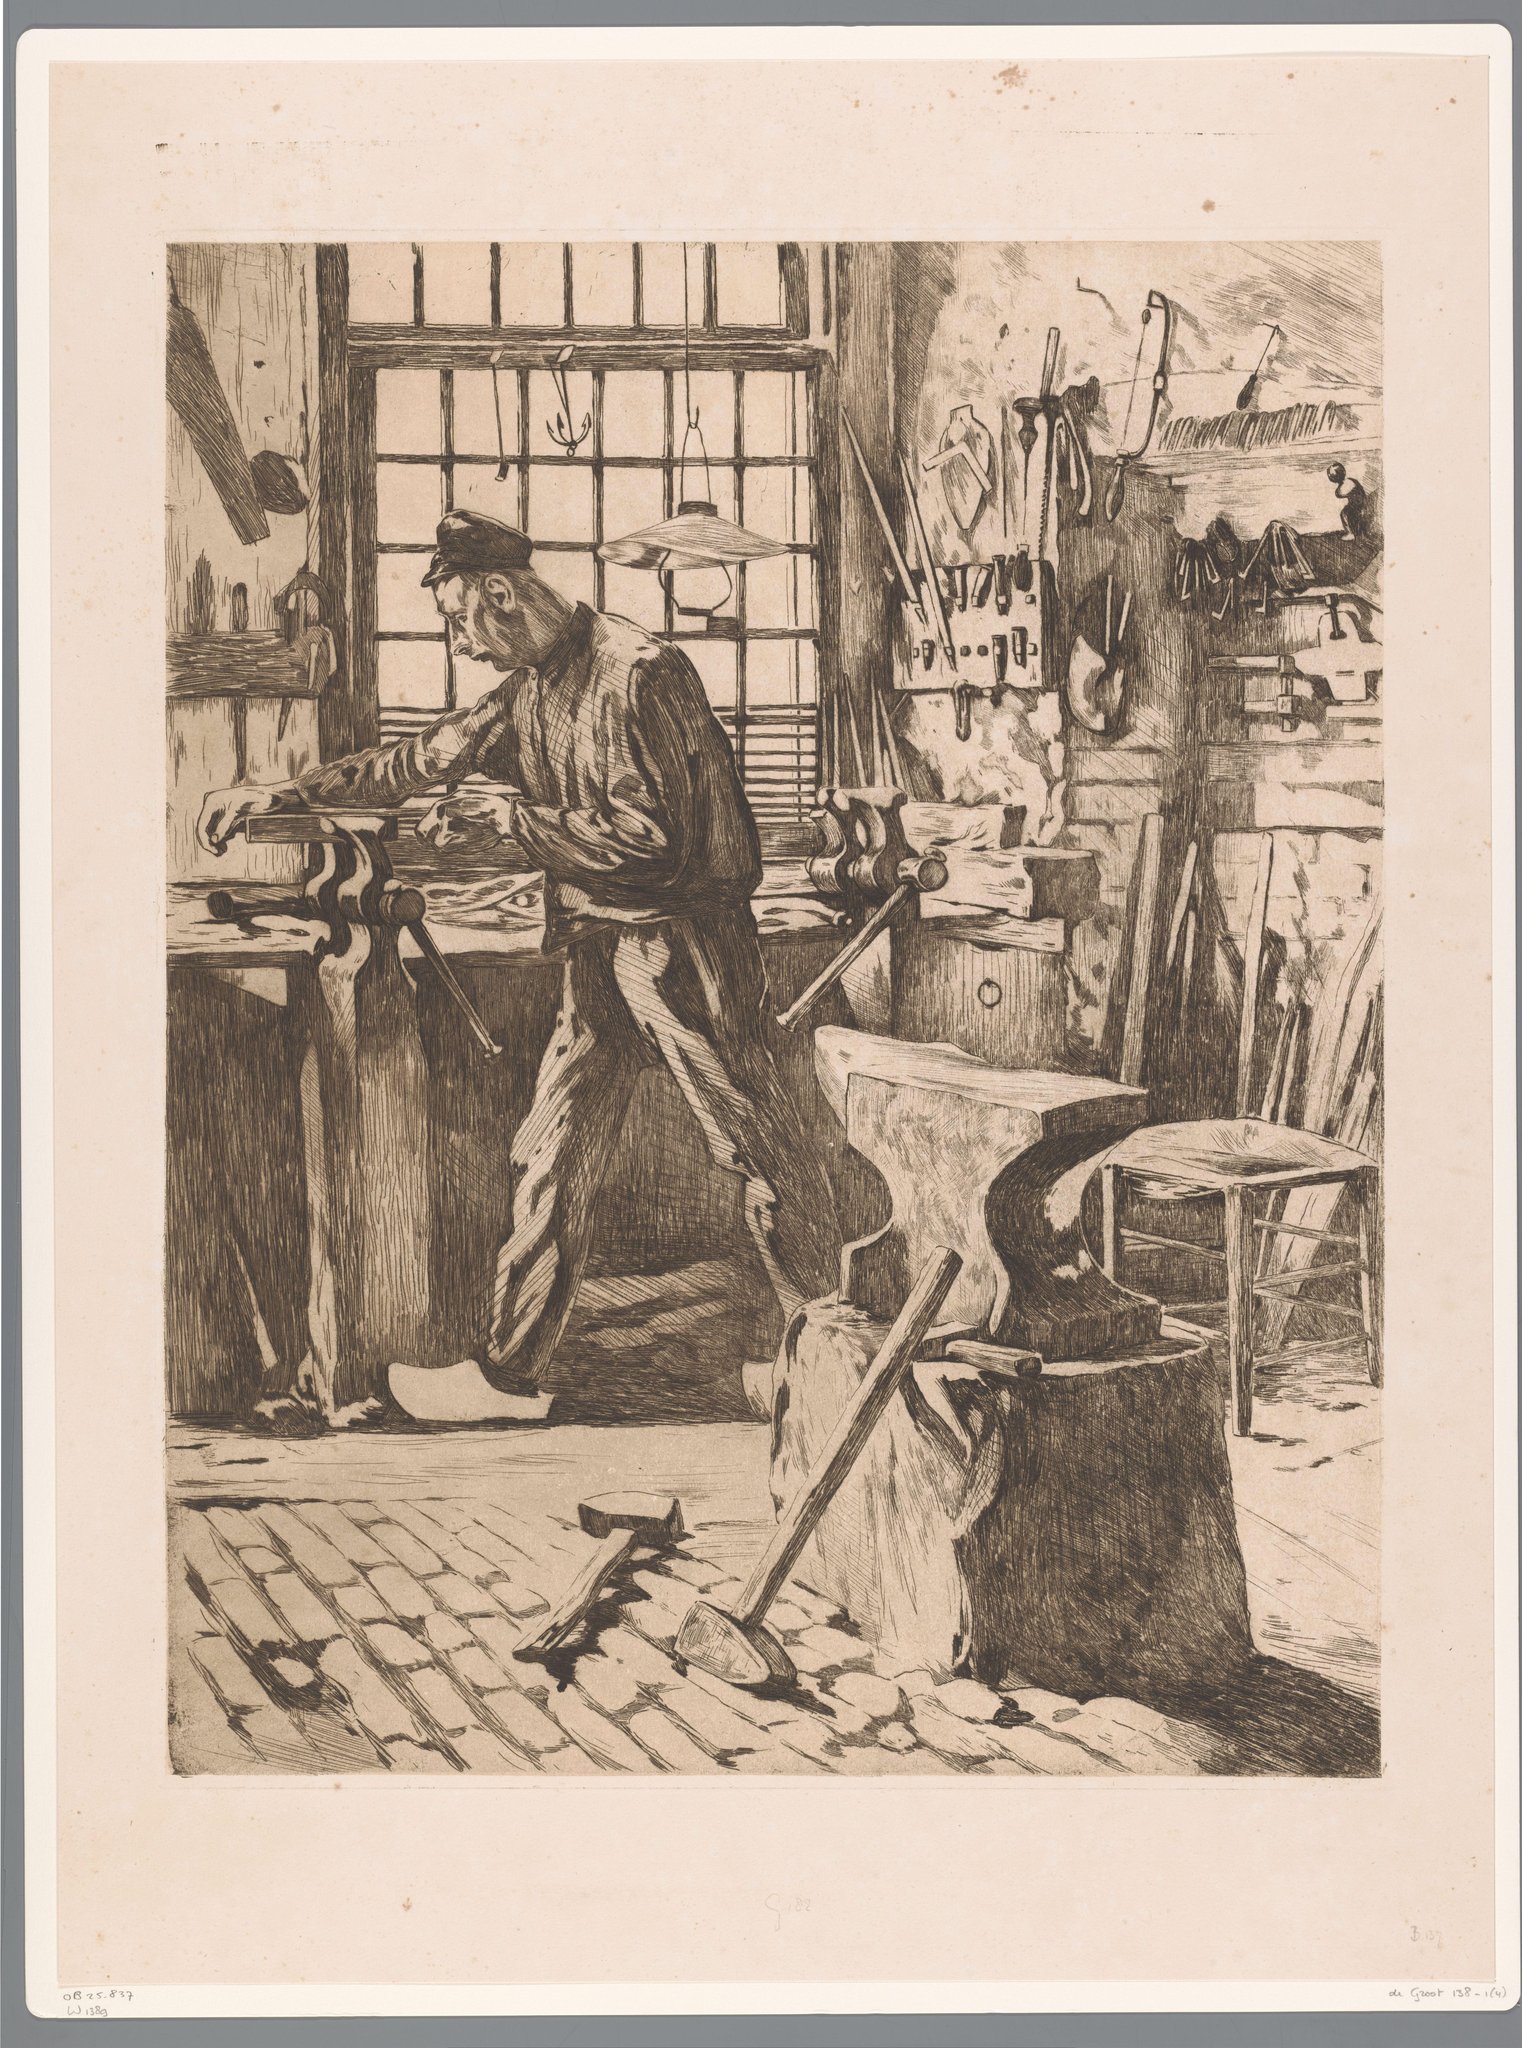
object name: print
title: Dorpssmid voor het raam (Bram)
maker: willem witsen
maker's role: draughtsman, painter, print maker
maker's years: 1860-1923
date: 1908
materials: paper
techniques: etching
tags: smith, blacksmith (+ men (labourers)), tools, aids, implements ~ crafts and industries: vice, wijk bij duurstede